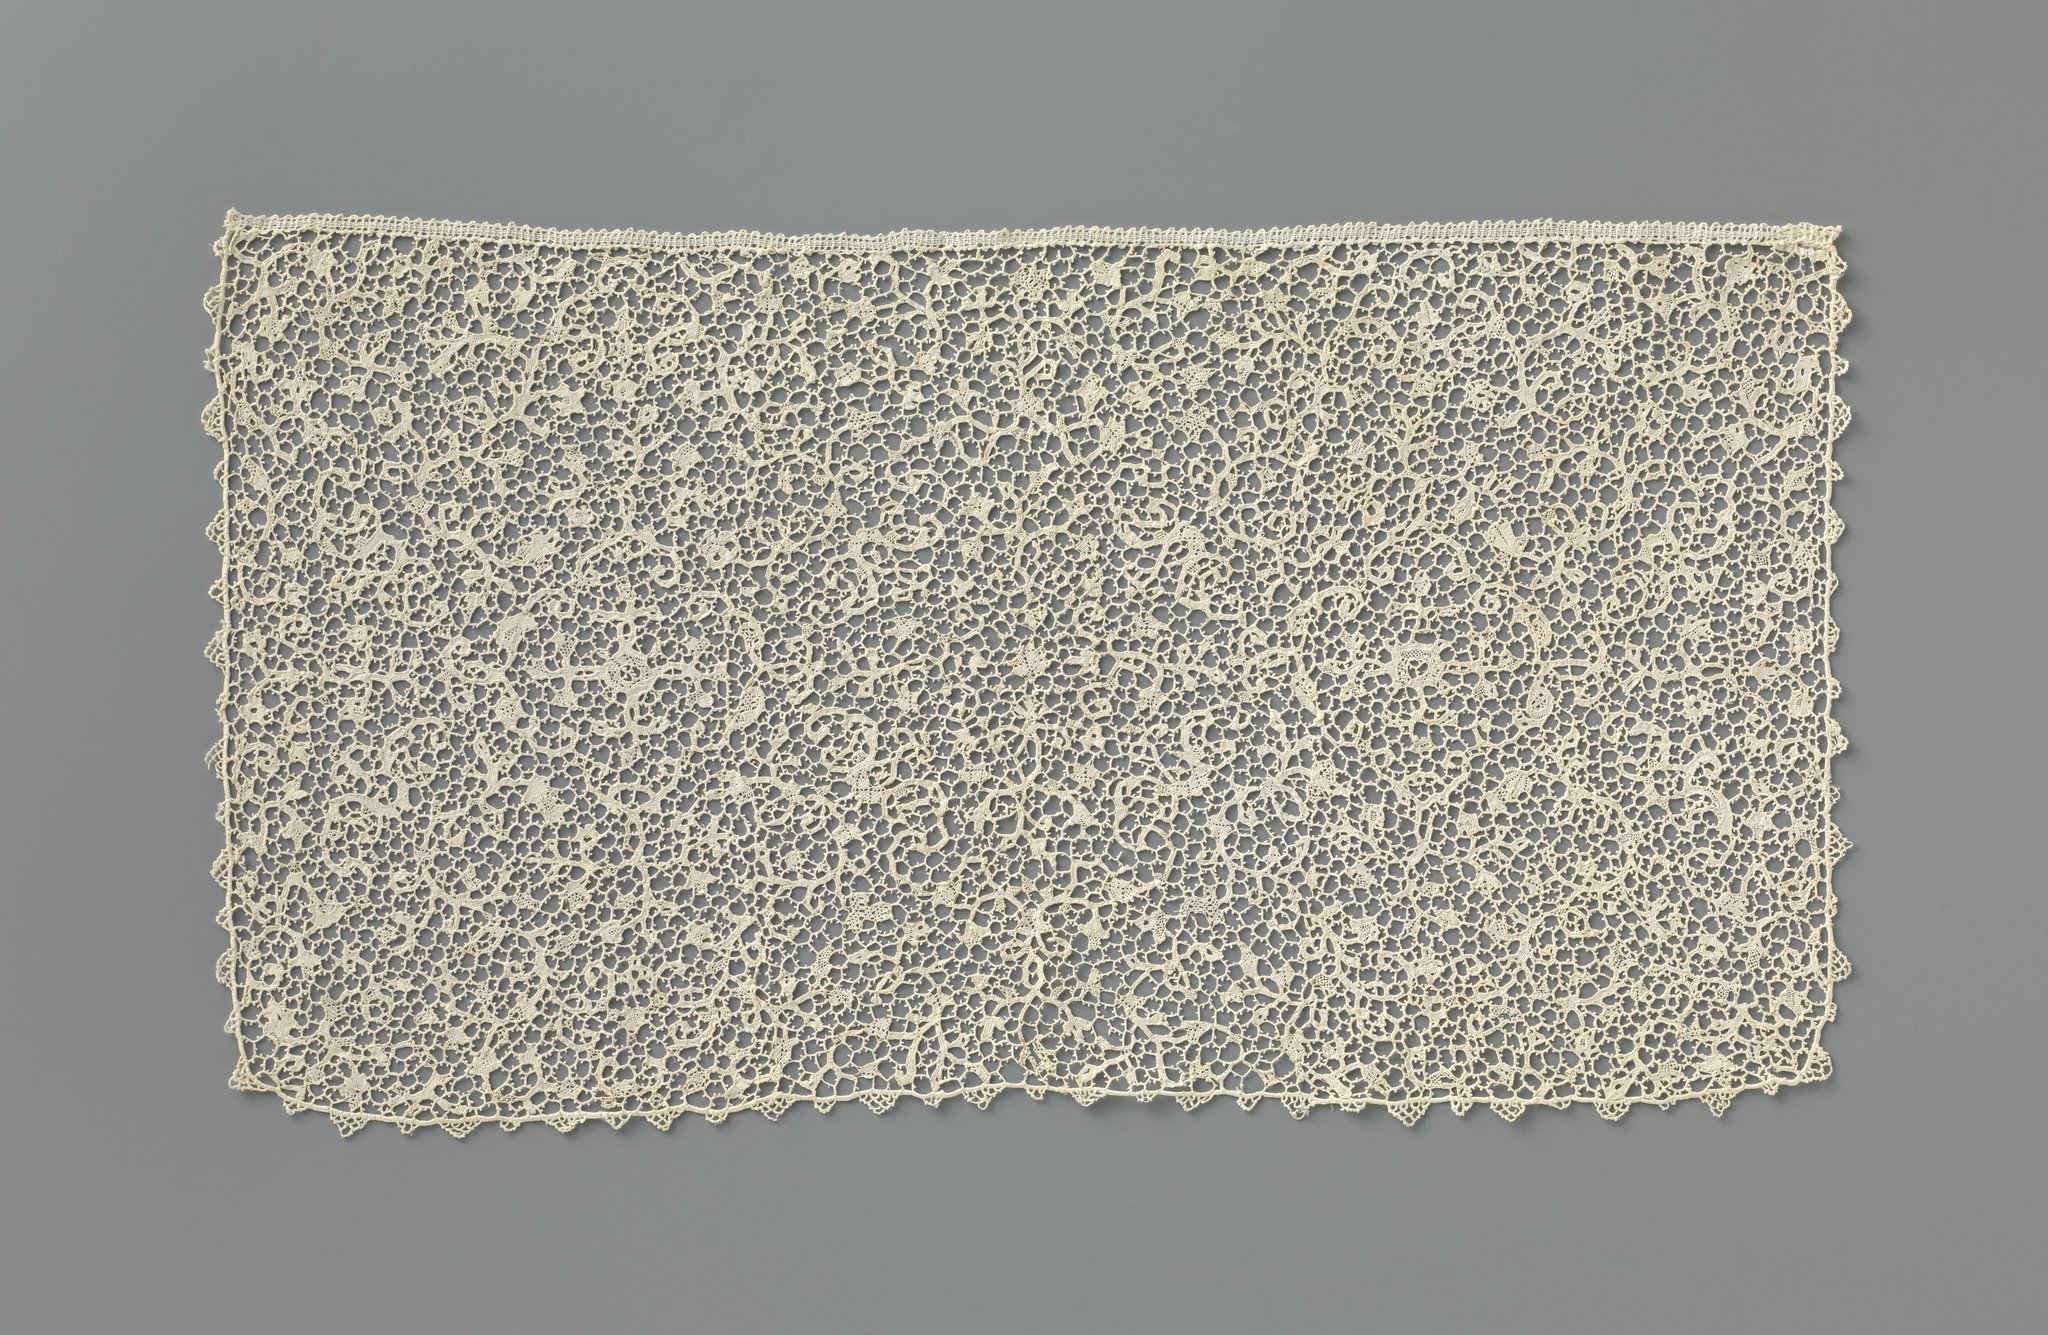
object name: dasslip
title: Dasslip van naaldkant met ruitvormige ranken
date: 1700-1724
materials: linen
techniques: flat venetian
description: Dasslip van naturelkleurige naaldkant: platte Venetiaanse kant of point de France. Op een grove zeshoekige maasgrond staat een ten opzichte van twee elkaar kruisende assen symmetrisch decor. In het hart staat een grote ruitvorm, die aan de linker en rechter buitenzijde gehalveerd terugkomt. Zij zijn verbonden door een kleinere ruit waarin een gelijkarmig kruis. De grote ruiten vertonen vier van C-voluten gevormde, onleesbare monogrammen(?). Het tussenliggende veld is gevuld met spiraalranken met kleine bloempjes en knopjes. Aan drie zijden een rechte lijn met puntjes, om en om groot en klein.